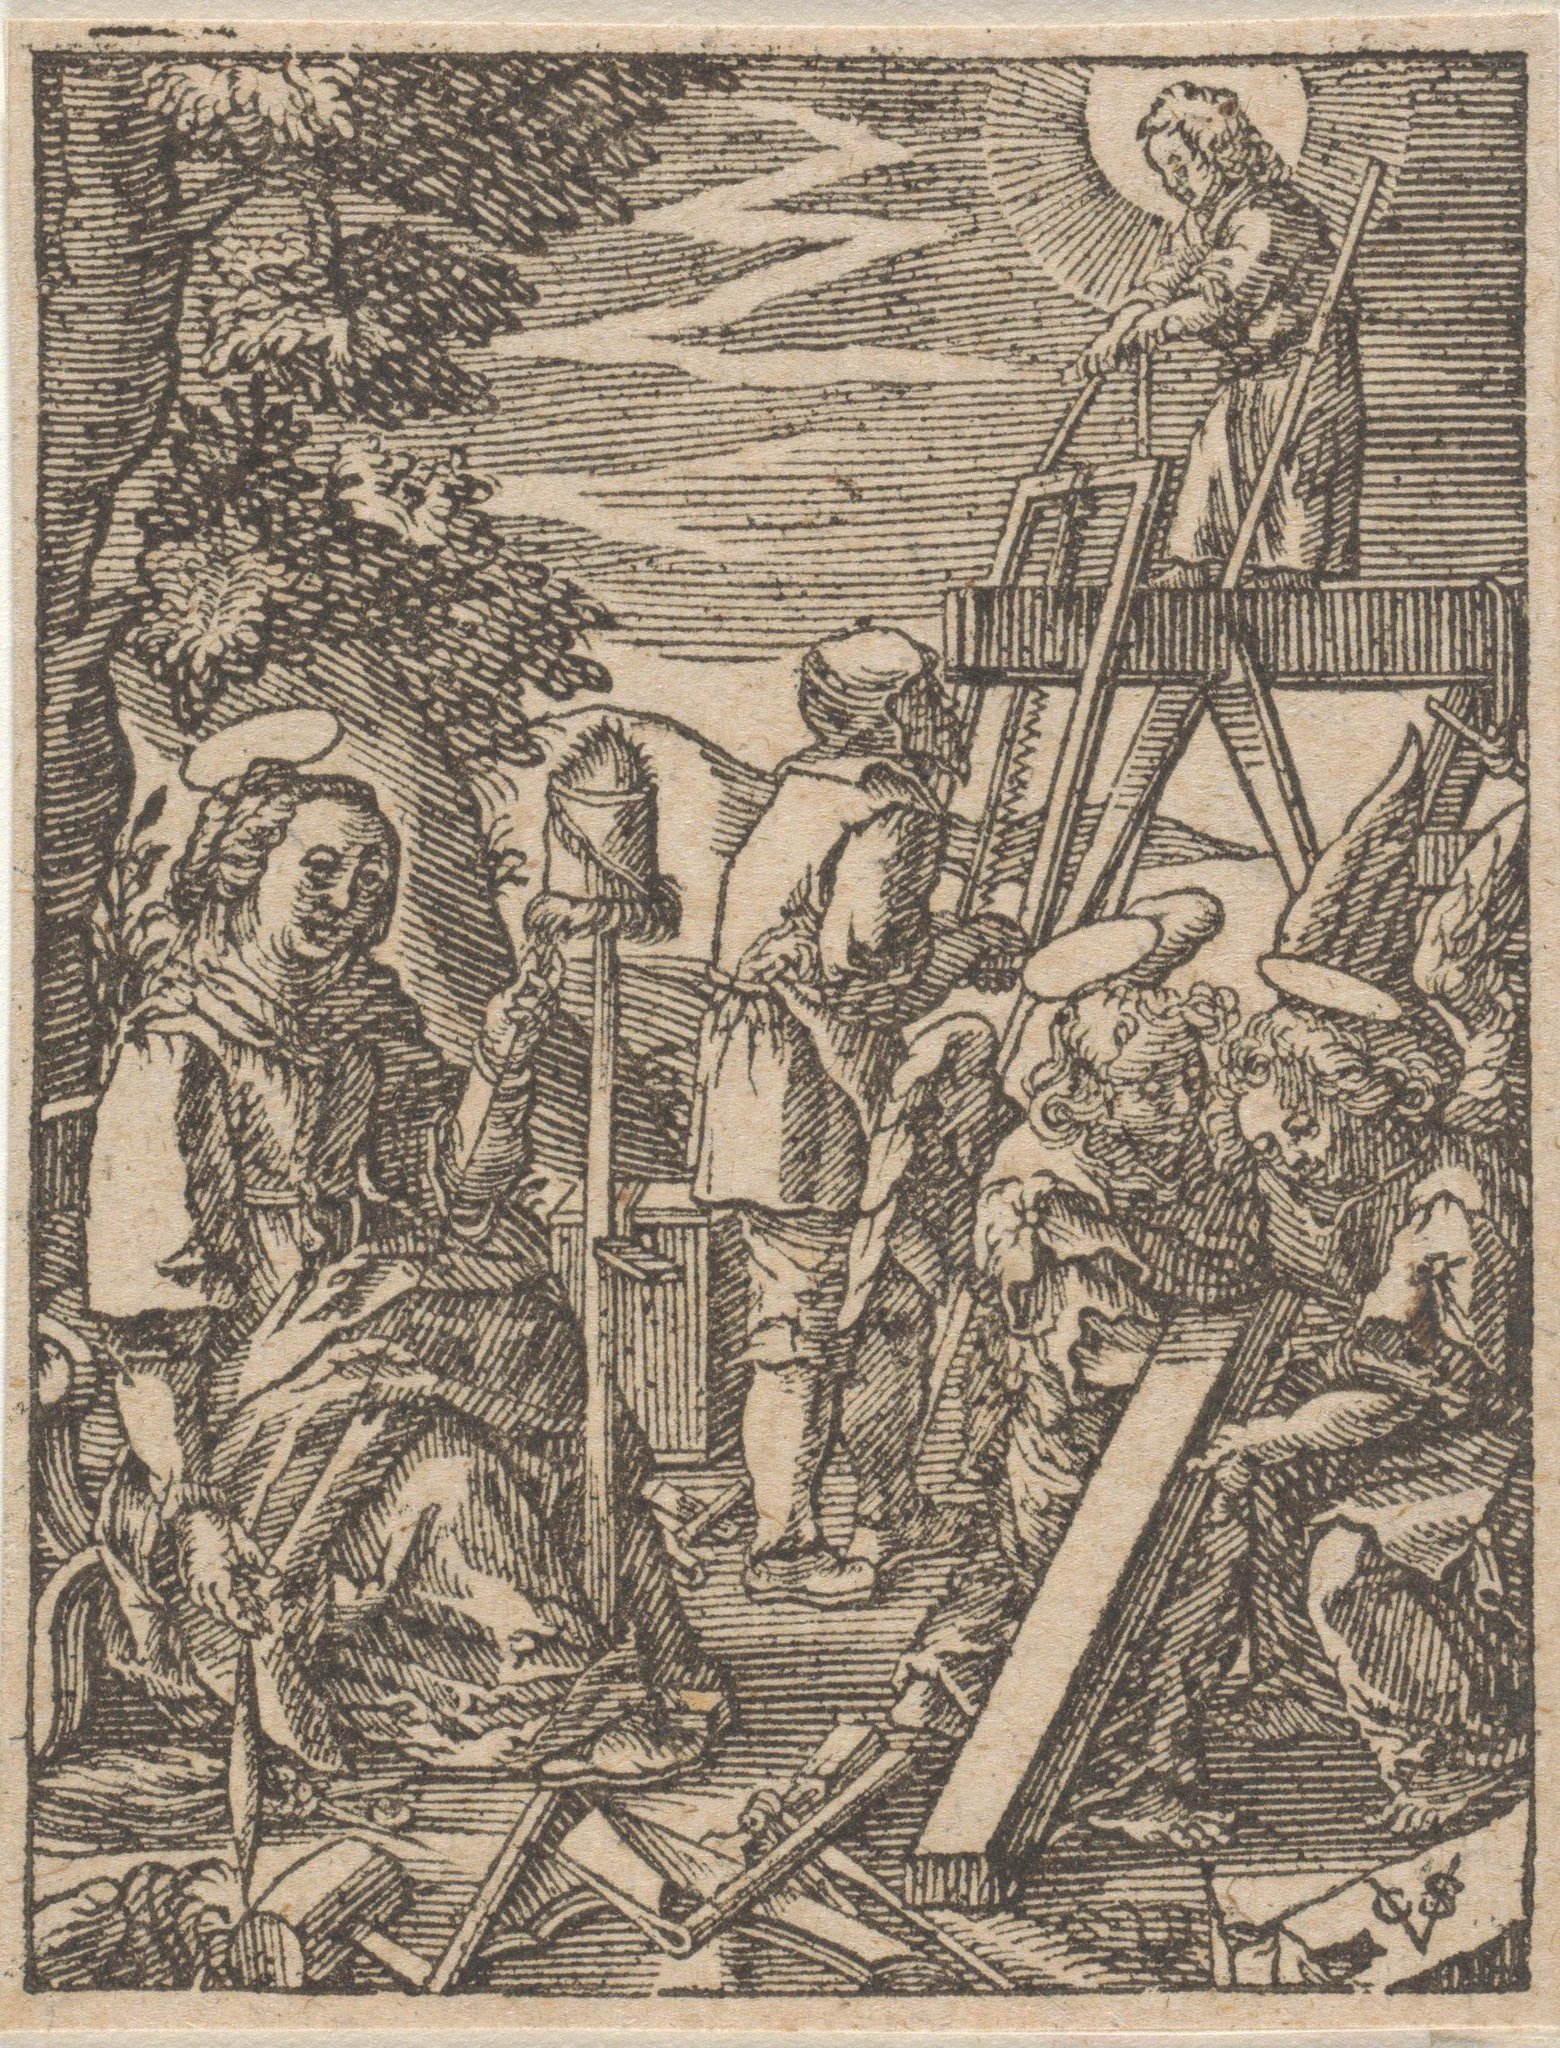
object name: print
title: De kindsheyd onses heeren Iesu Christi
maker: christoffel van sichem (ii)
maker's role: print maker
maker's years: 1581-1658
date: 1617-1658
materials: paper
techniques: woodcut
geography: amsterdam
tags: joseph and the christ-child ~ daily life in nazareth, angels, household occupations of mary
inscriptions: collector's mark: Lugt 240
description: Het Christuskind is samen met zijn vader Jozef aan het zagen. Twee engelen op de voorgrond tillen een balk op. Maria is garen aan het spinnen.